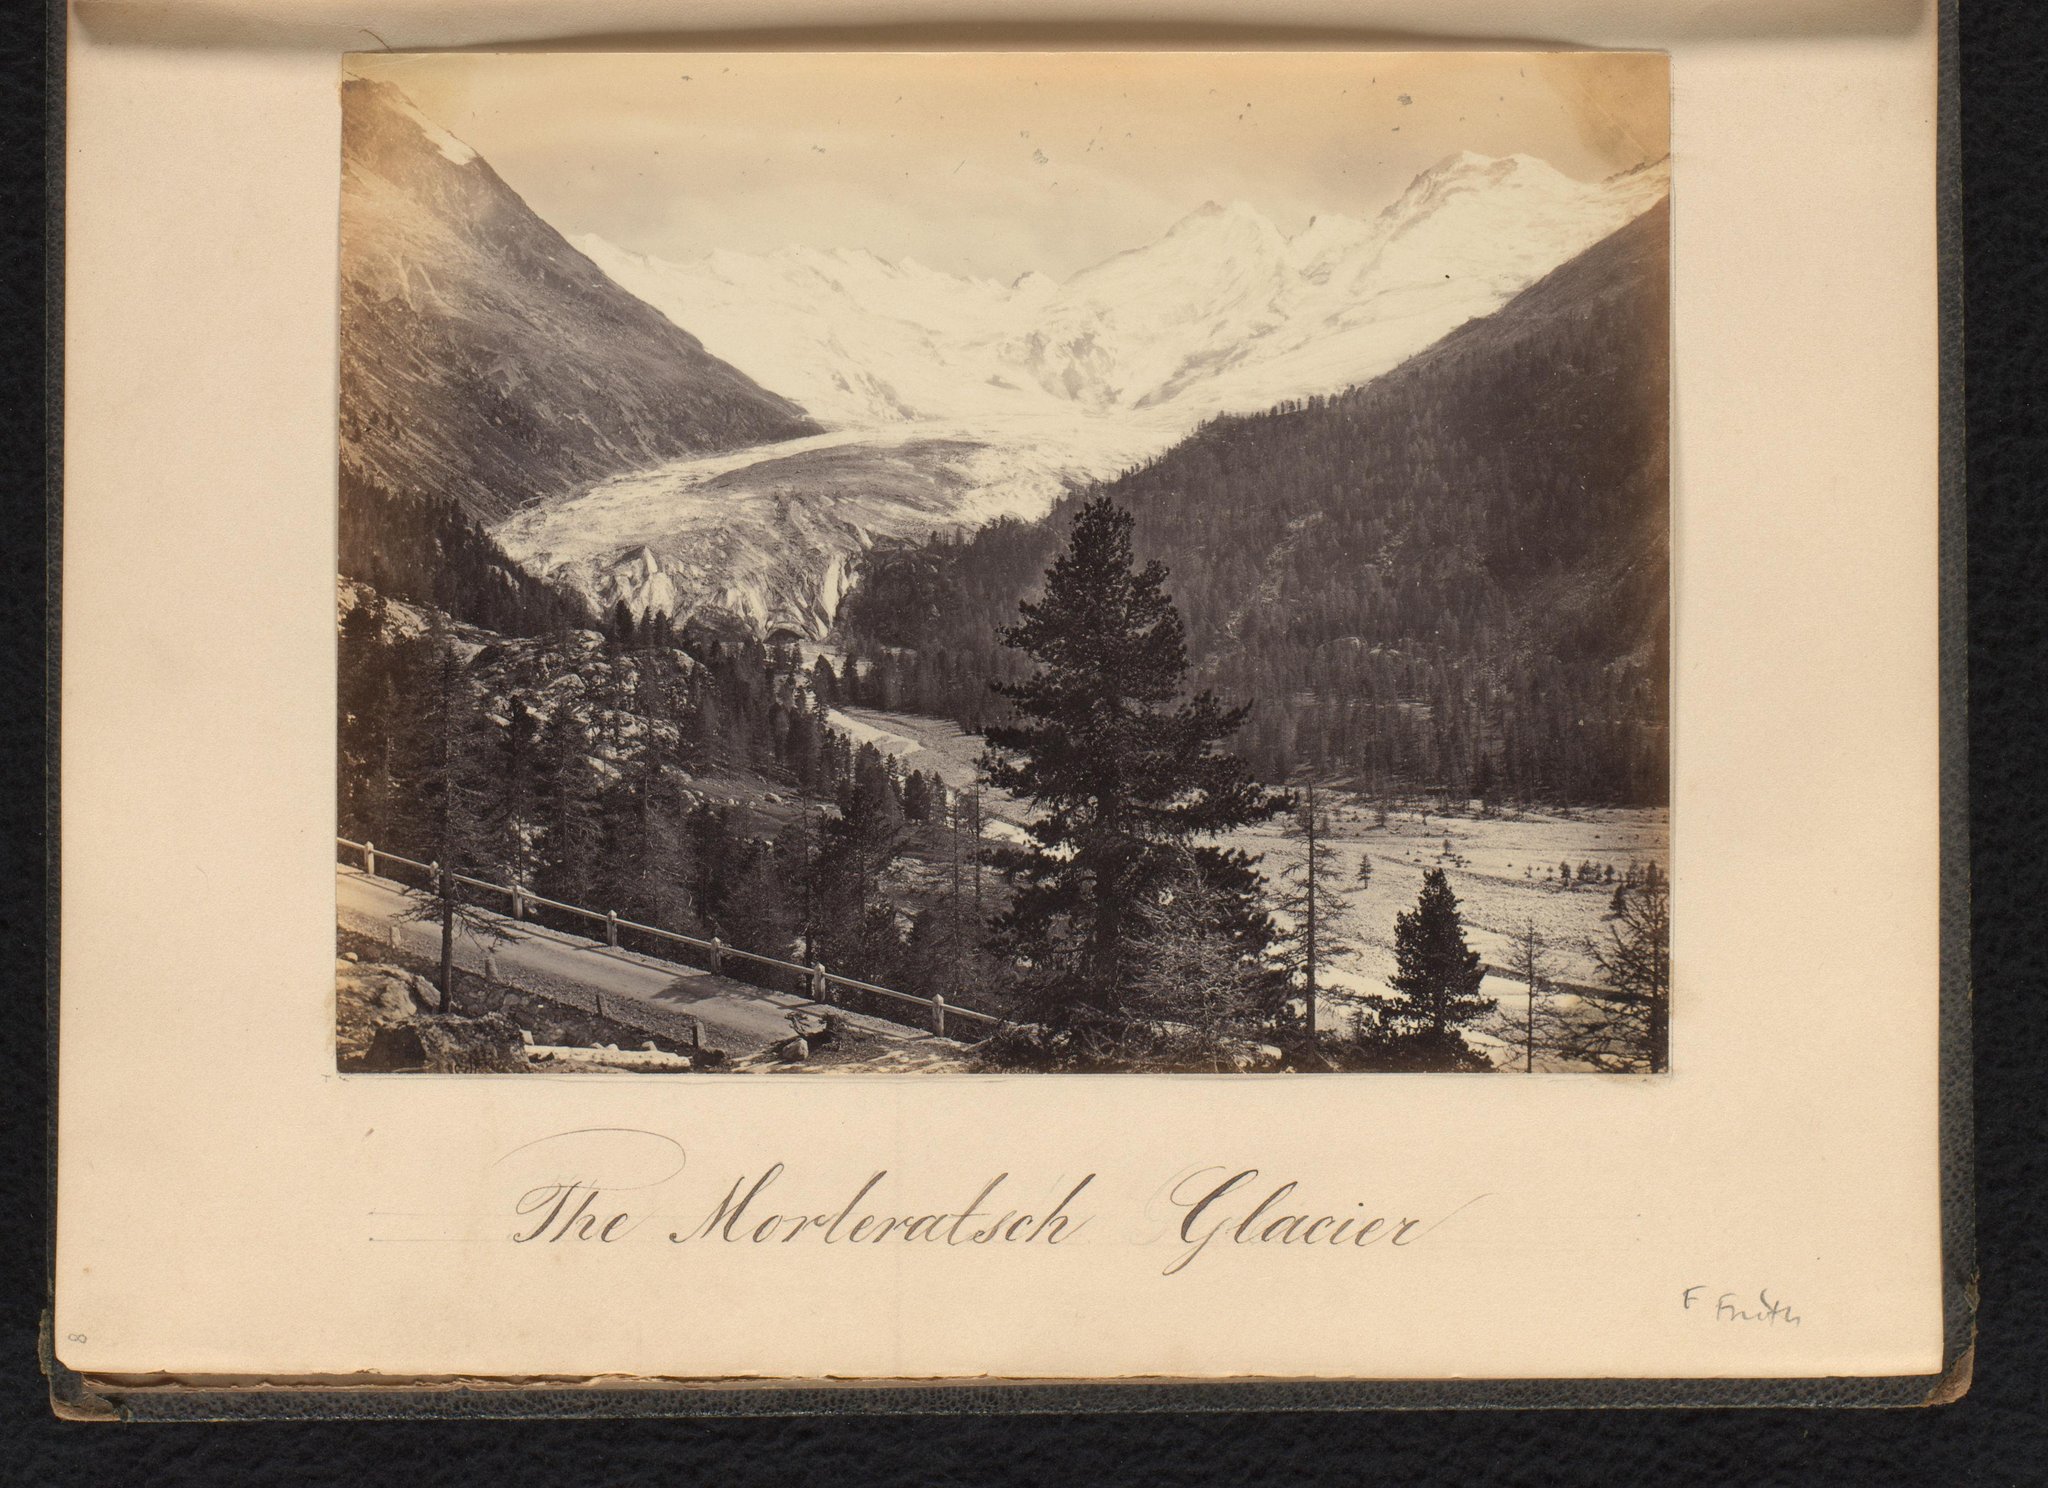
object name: album leaf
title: The Morteratsch Glacier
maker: francis frith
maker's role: publisher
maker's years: 1822-1898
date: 1860-1870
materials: paper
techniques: albumen print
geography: graubunden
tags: glacier